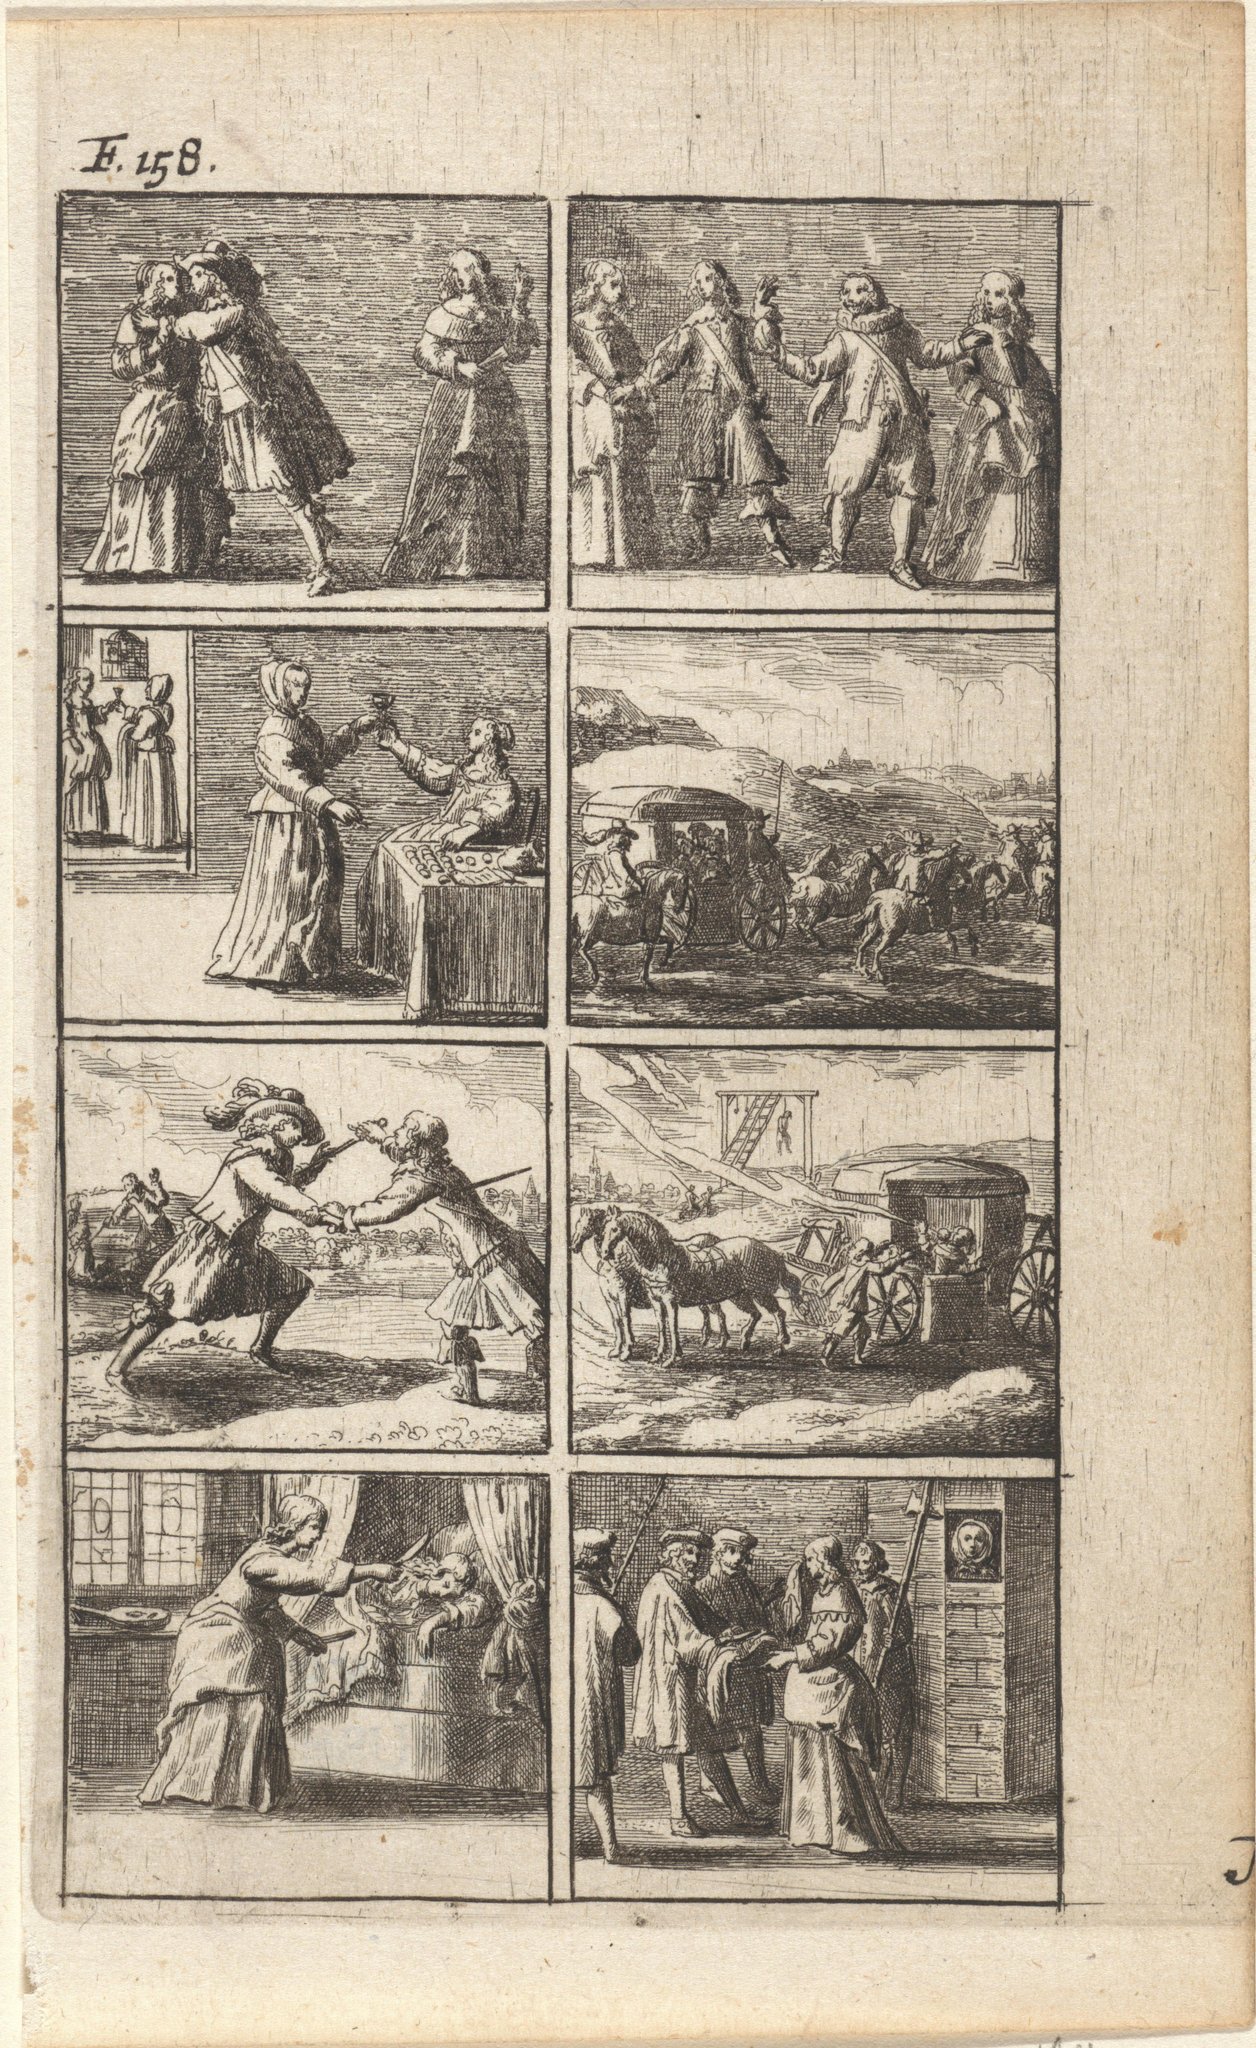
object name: book illustration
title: Verhaal met voorstellingen van moord en doodstraf (F. 158.)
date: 1667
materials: paper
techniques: etching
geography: netherlands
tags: death penalty, execution, murder, fighting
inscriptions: collector's mark: Lugt 2760, collector's mark: Lugt 2166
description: Verhaal in acht scènes met enkele voorstellingen van moord en doodstraf. Onder andere een zwaardgevecht, een blikseminslag in een koets en een voorstelling van een vrouw die op het punt staat een slapend persoon neer te steken. Linksboven: F. 158.